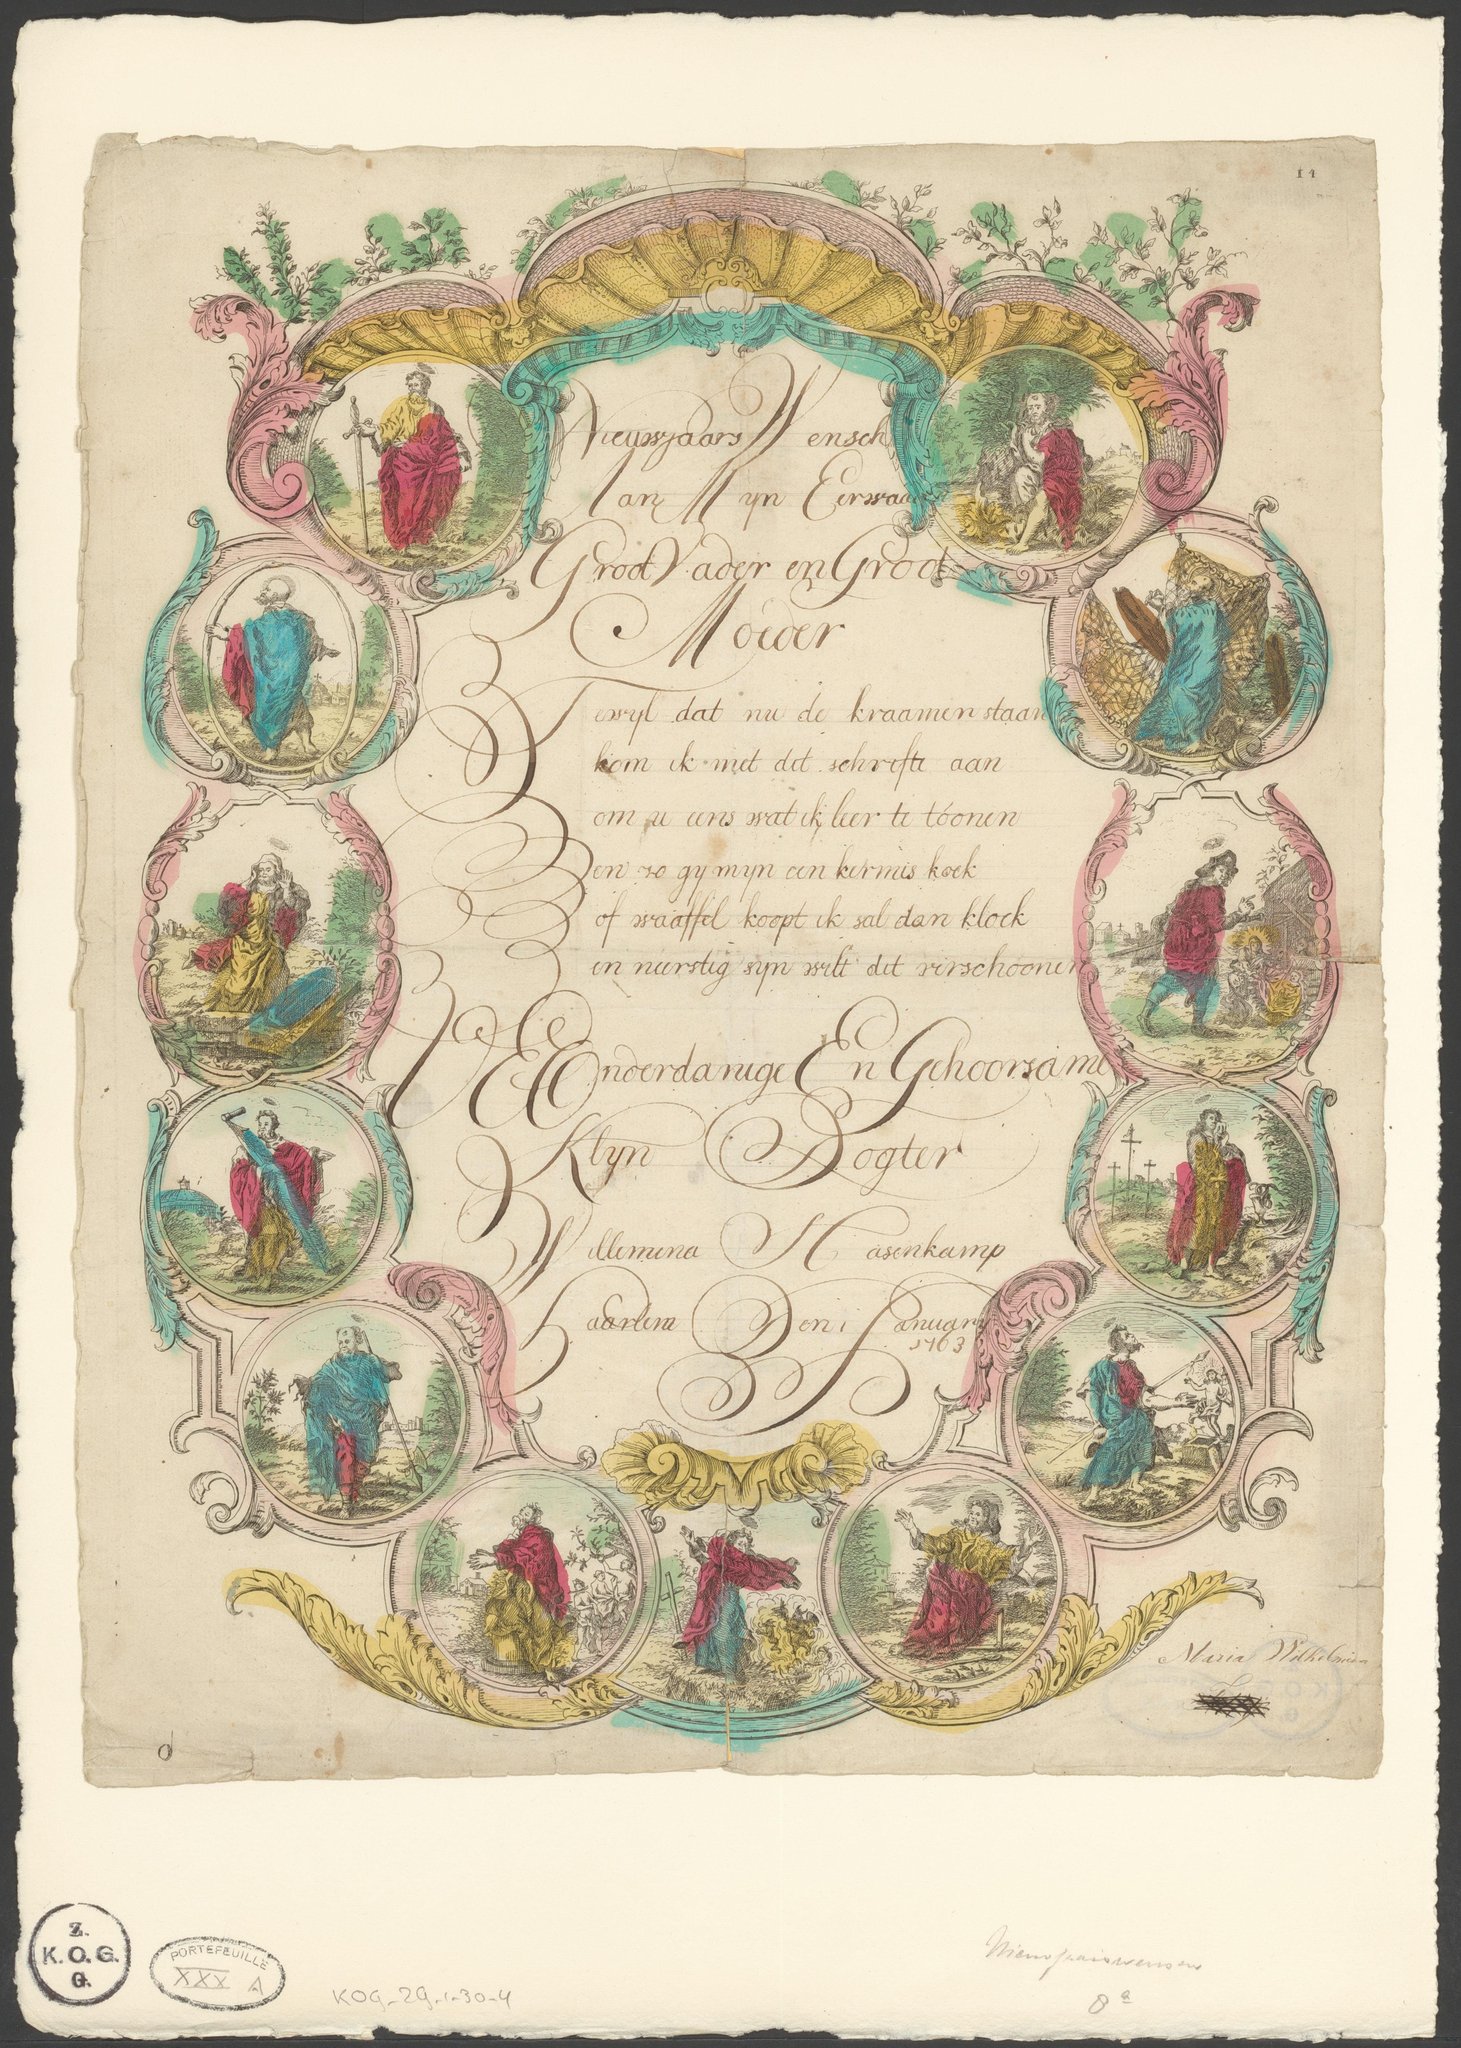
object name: wensbrief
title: Nieuwjaarswens van Willemina Hasenkamp, 1763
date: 1763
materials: ink, paper, watercolor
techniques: etching, hand coloring, writing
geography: haarlem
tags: january 1 (~ festivities), other groups of apostles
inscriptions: collector's mark: Lugt 1641, collector's mark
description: Nieuwjaarswens van Willemina Hasenkamp, 1763. Gericht aan haar grootvader en grootmoeder. Handgeschreven vers binnen een voorgedrukte omlijsting met de voorstellingen van de apostelen. Onderaan geschreven de naam 'Maria Wilhelmina'. Onderwerpsrubrieken binnen de Atlas Zeden en Gewoonten: Nieuwjaars- en kermiswenschen.